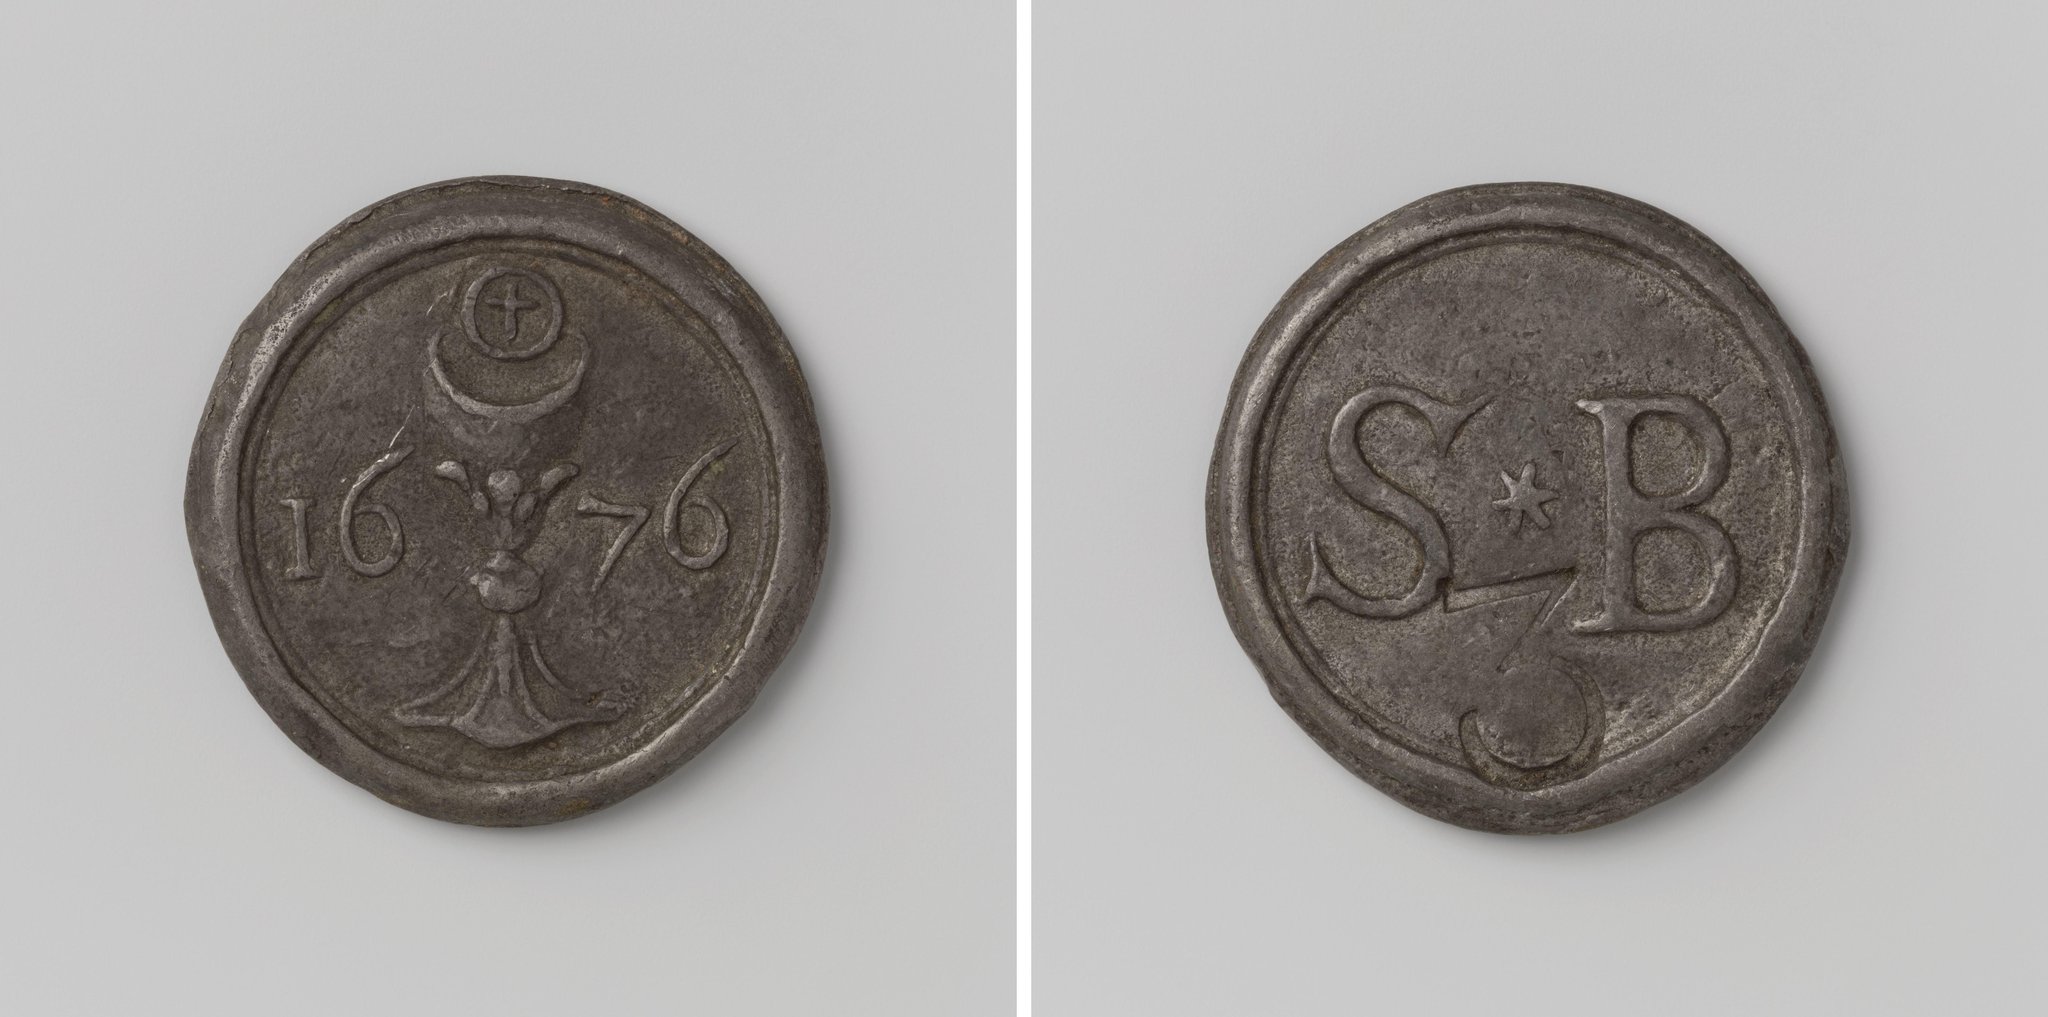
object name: devotional medal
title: Religieuze penning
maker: Anonymous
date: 1676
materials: lead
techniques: casting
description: Loden penning. Voorzijde: kelk met hostie tussen jaartal. Keerzijde: letters S en B, gescheiden door ster boven cijfer 3